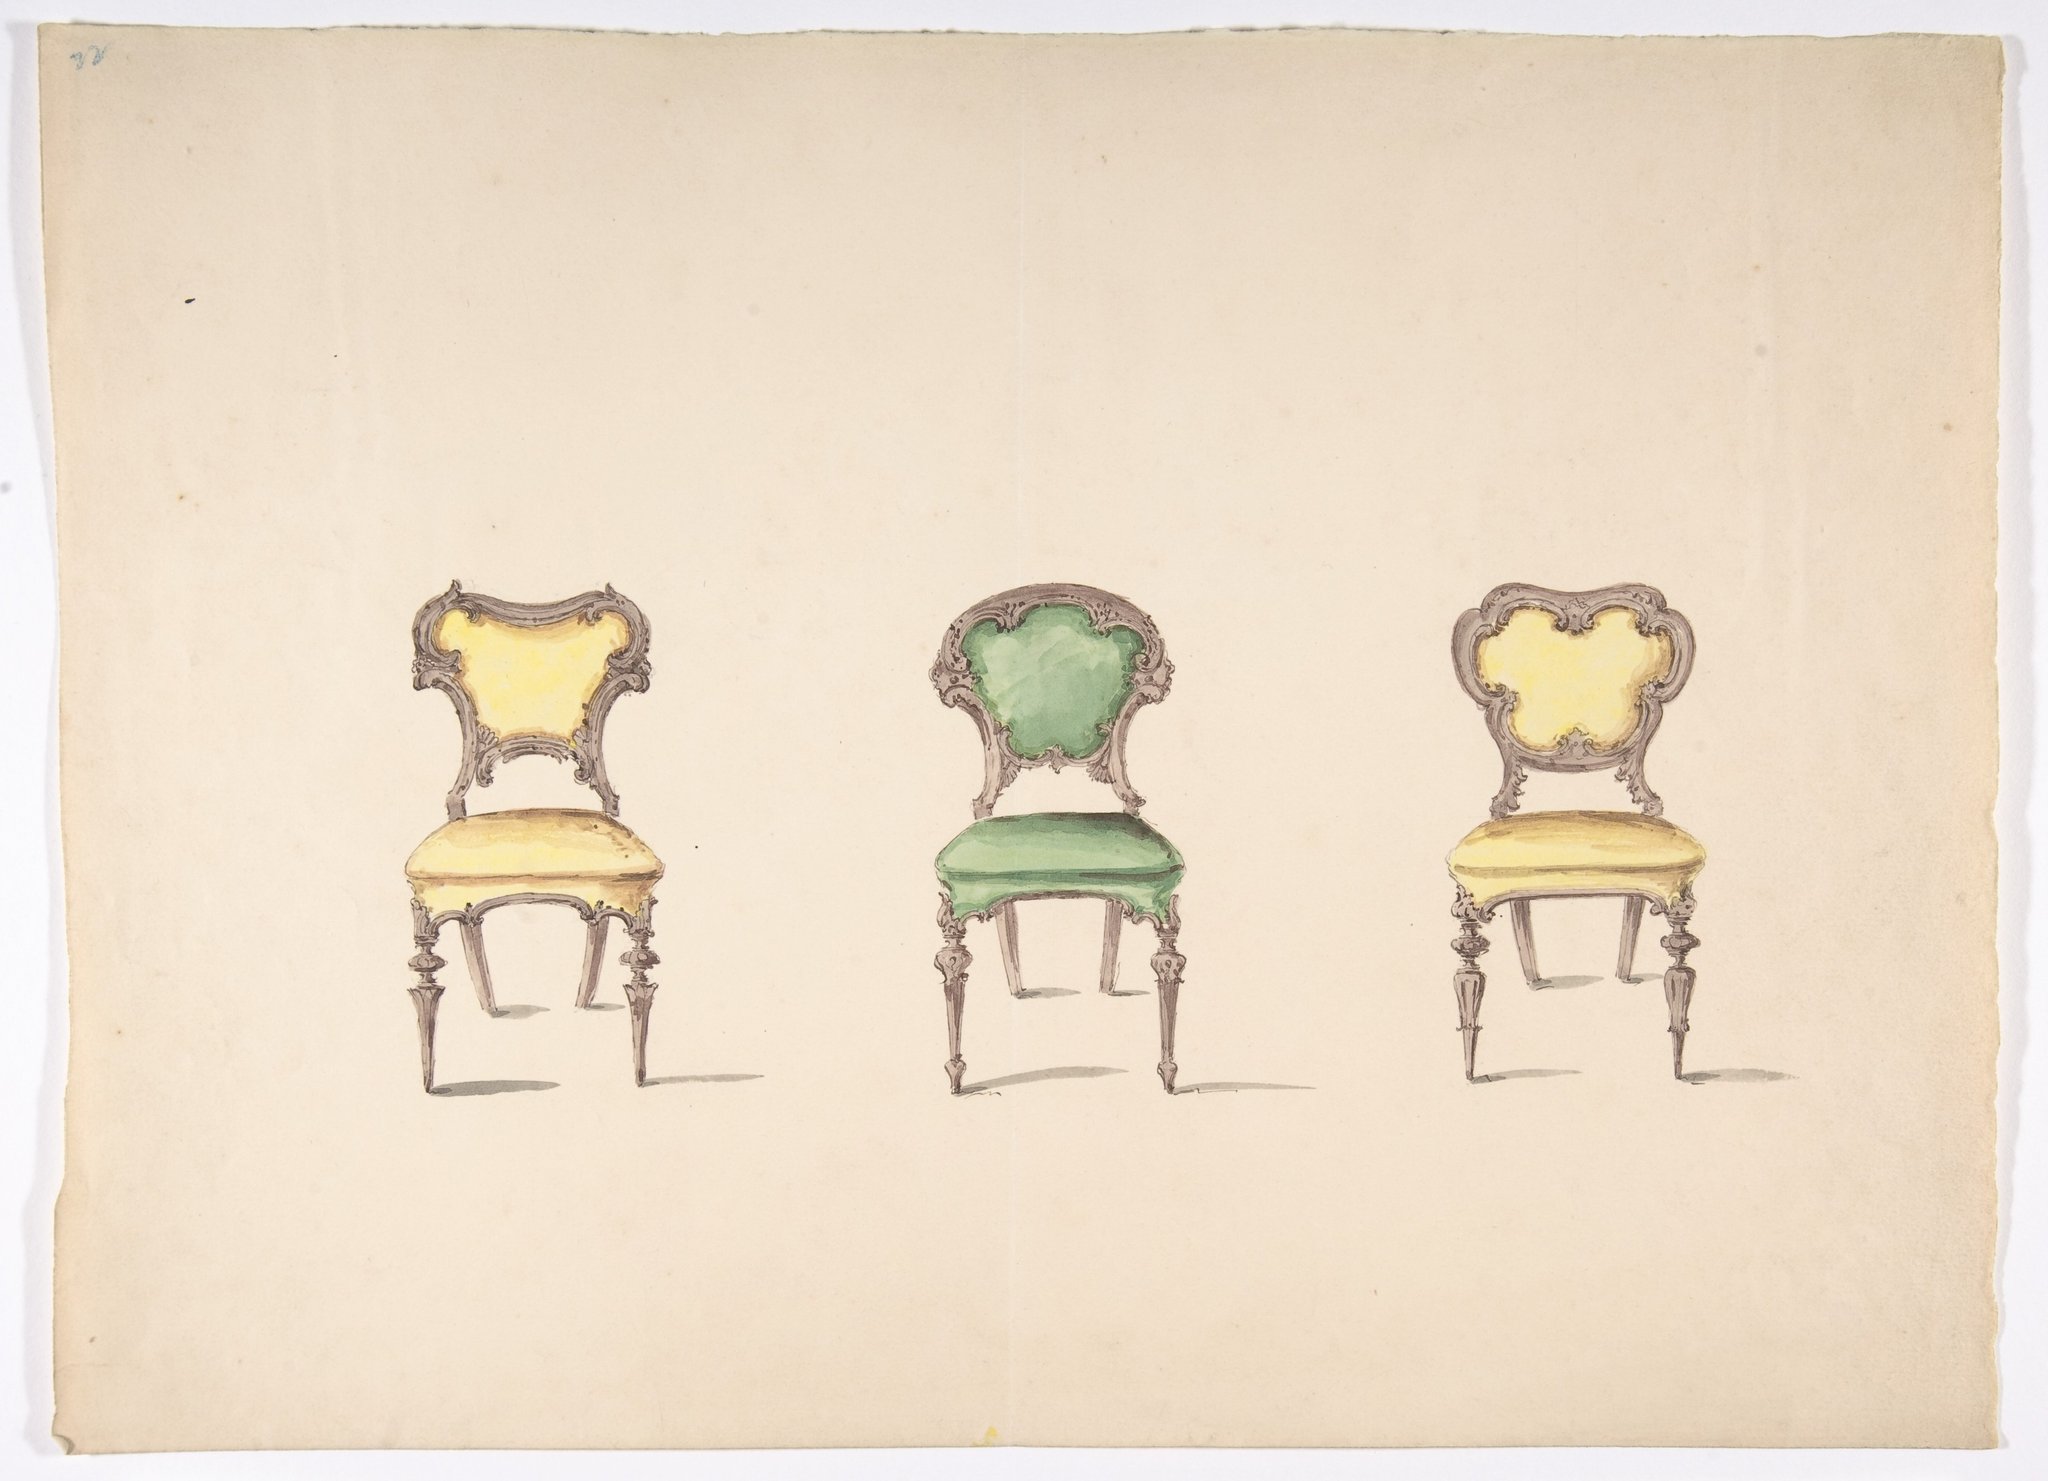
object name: drawing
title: Design for Three Chairs Upholstered in Green and Yellow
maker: anonymous, british, 19th century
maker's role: artist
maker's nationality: british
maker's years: 1800-1900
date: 1801-1833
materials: ink, watercolor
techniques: brush, pen, wash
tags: chairs